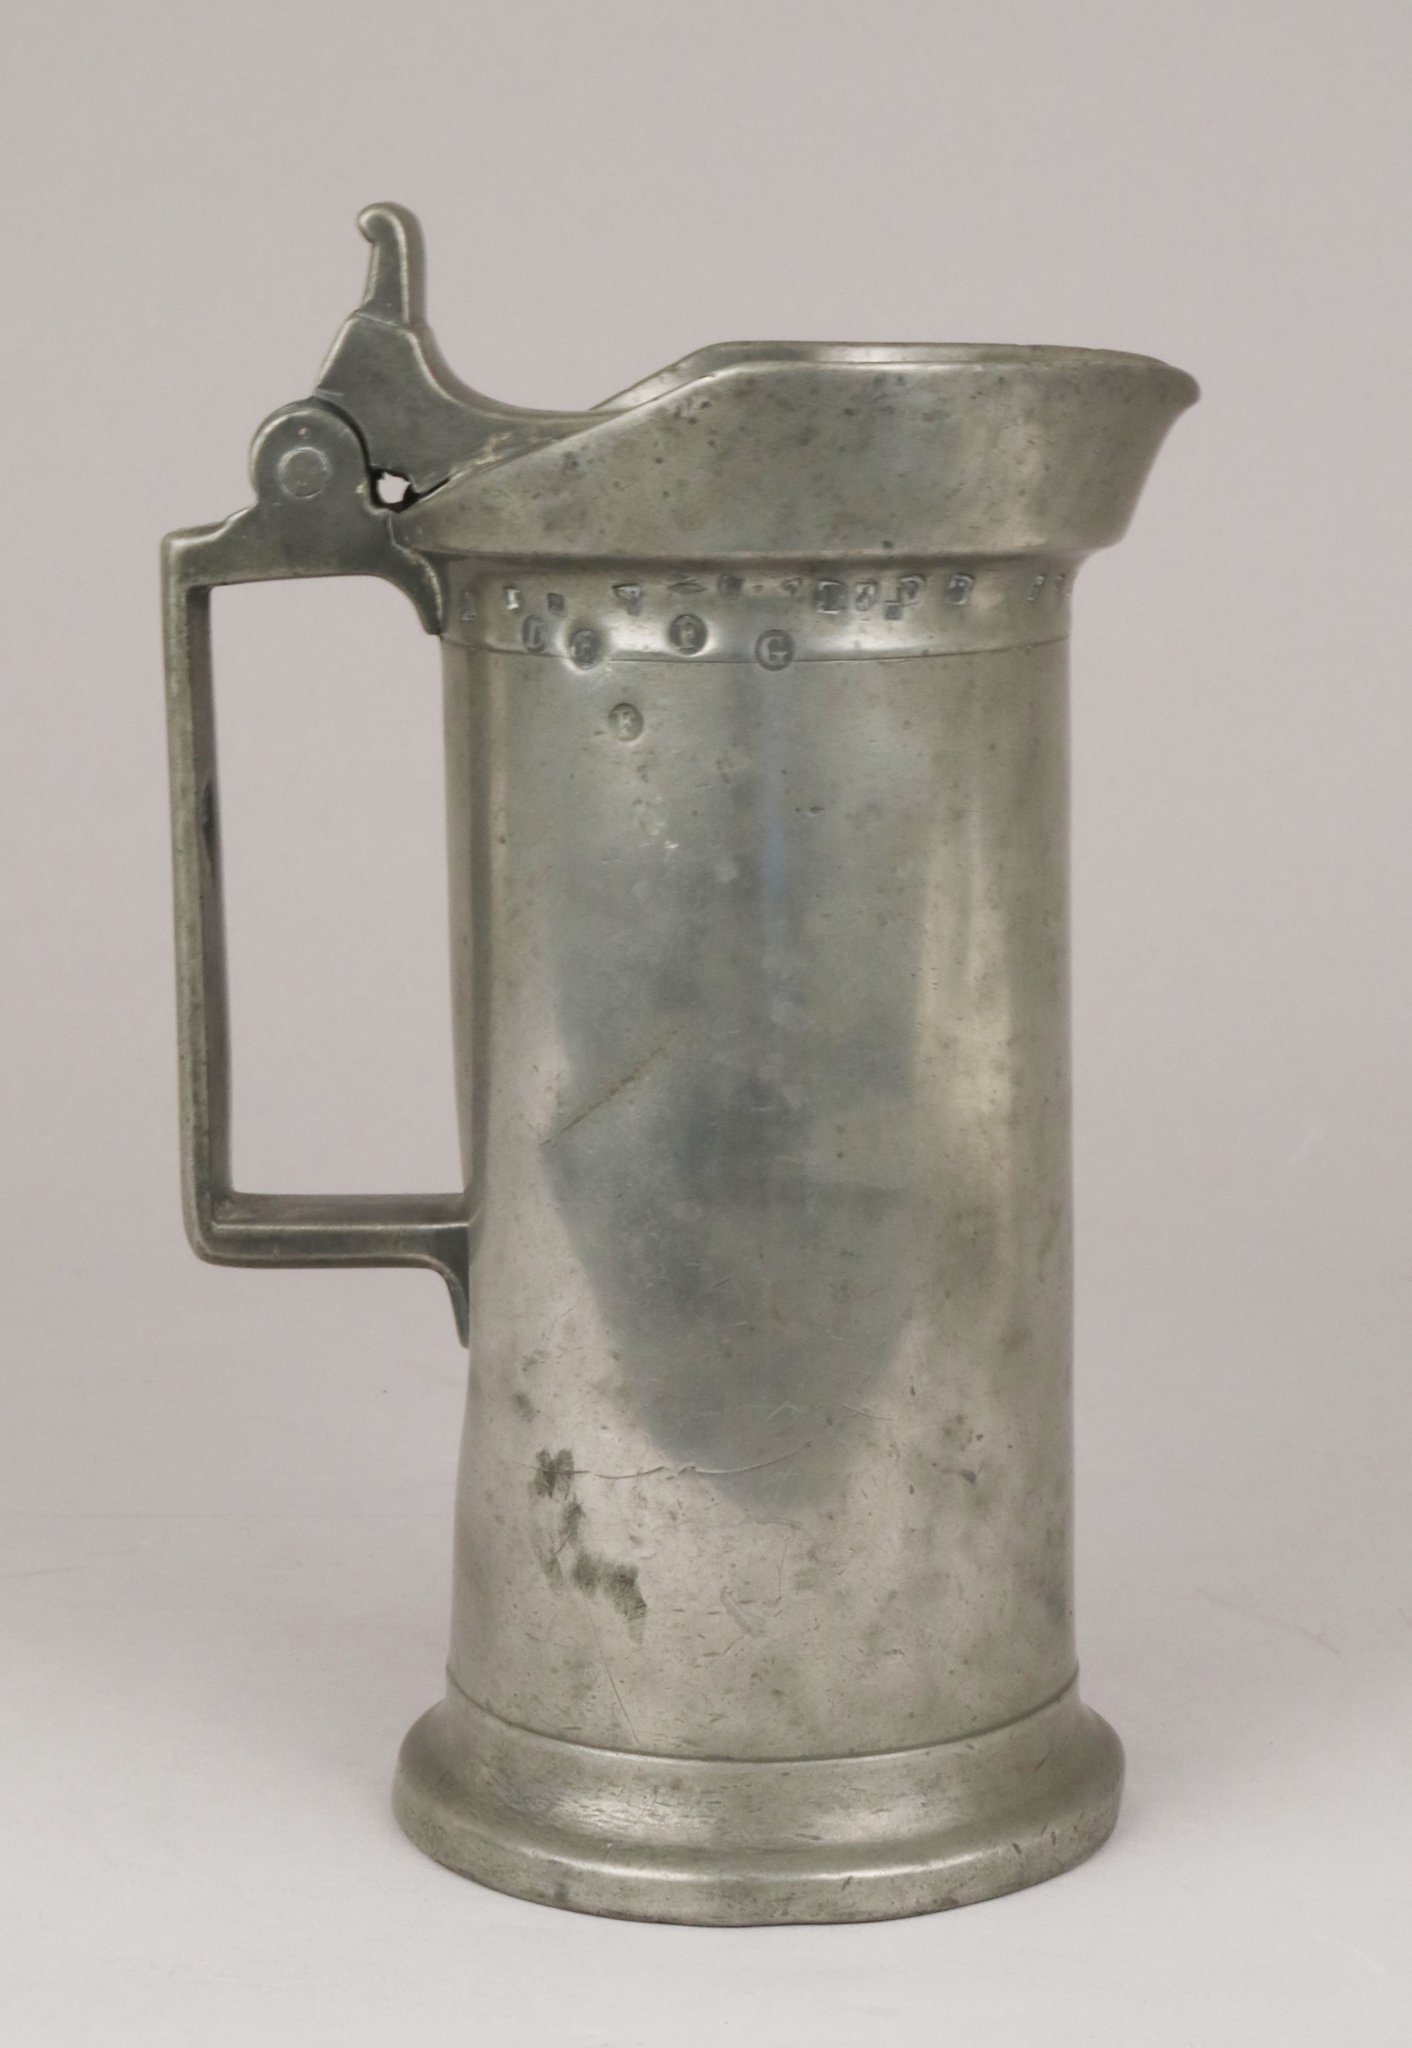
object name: measure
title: One litre measure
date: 1701-1800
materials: pewter